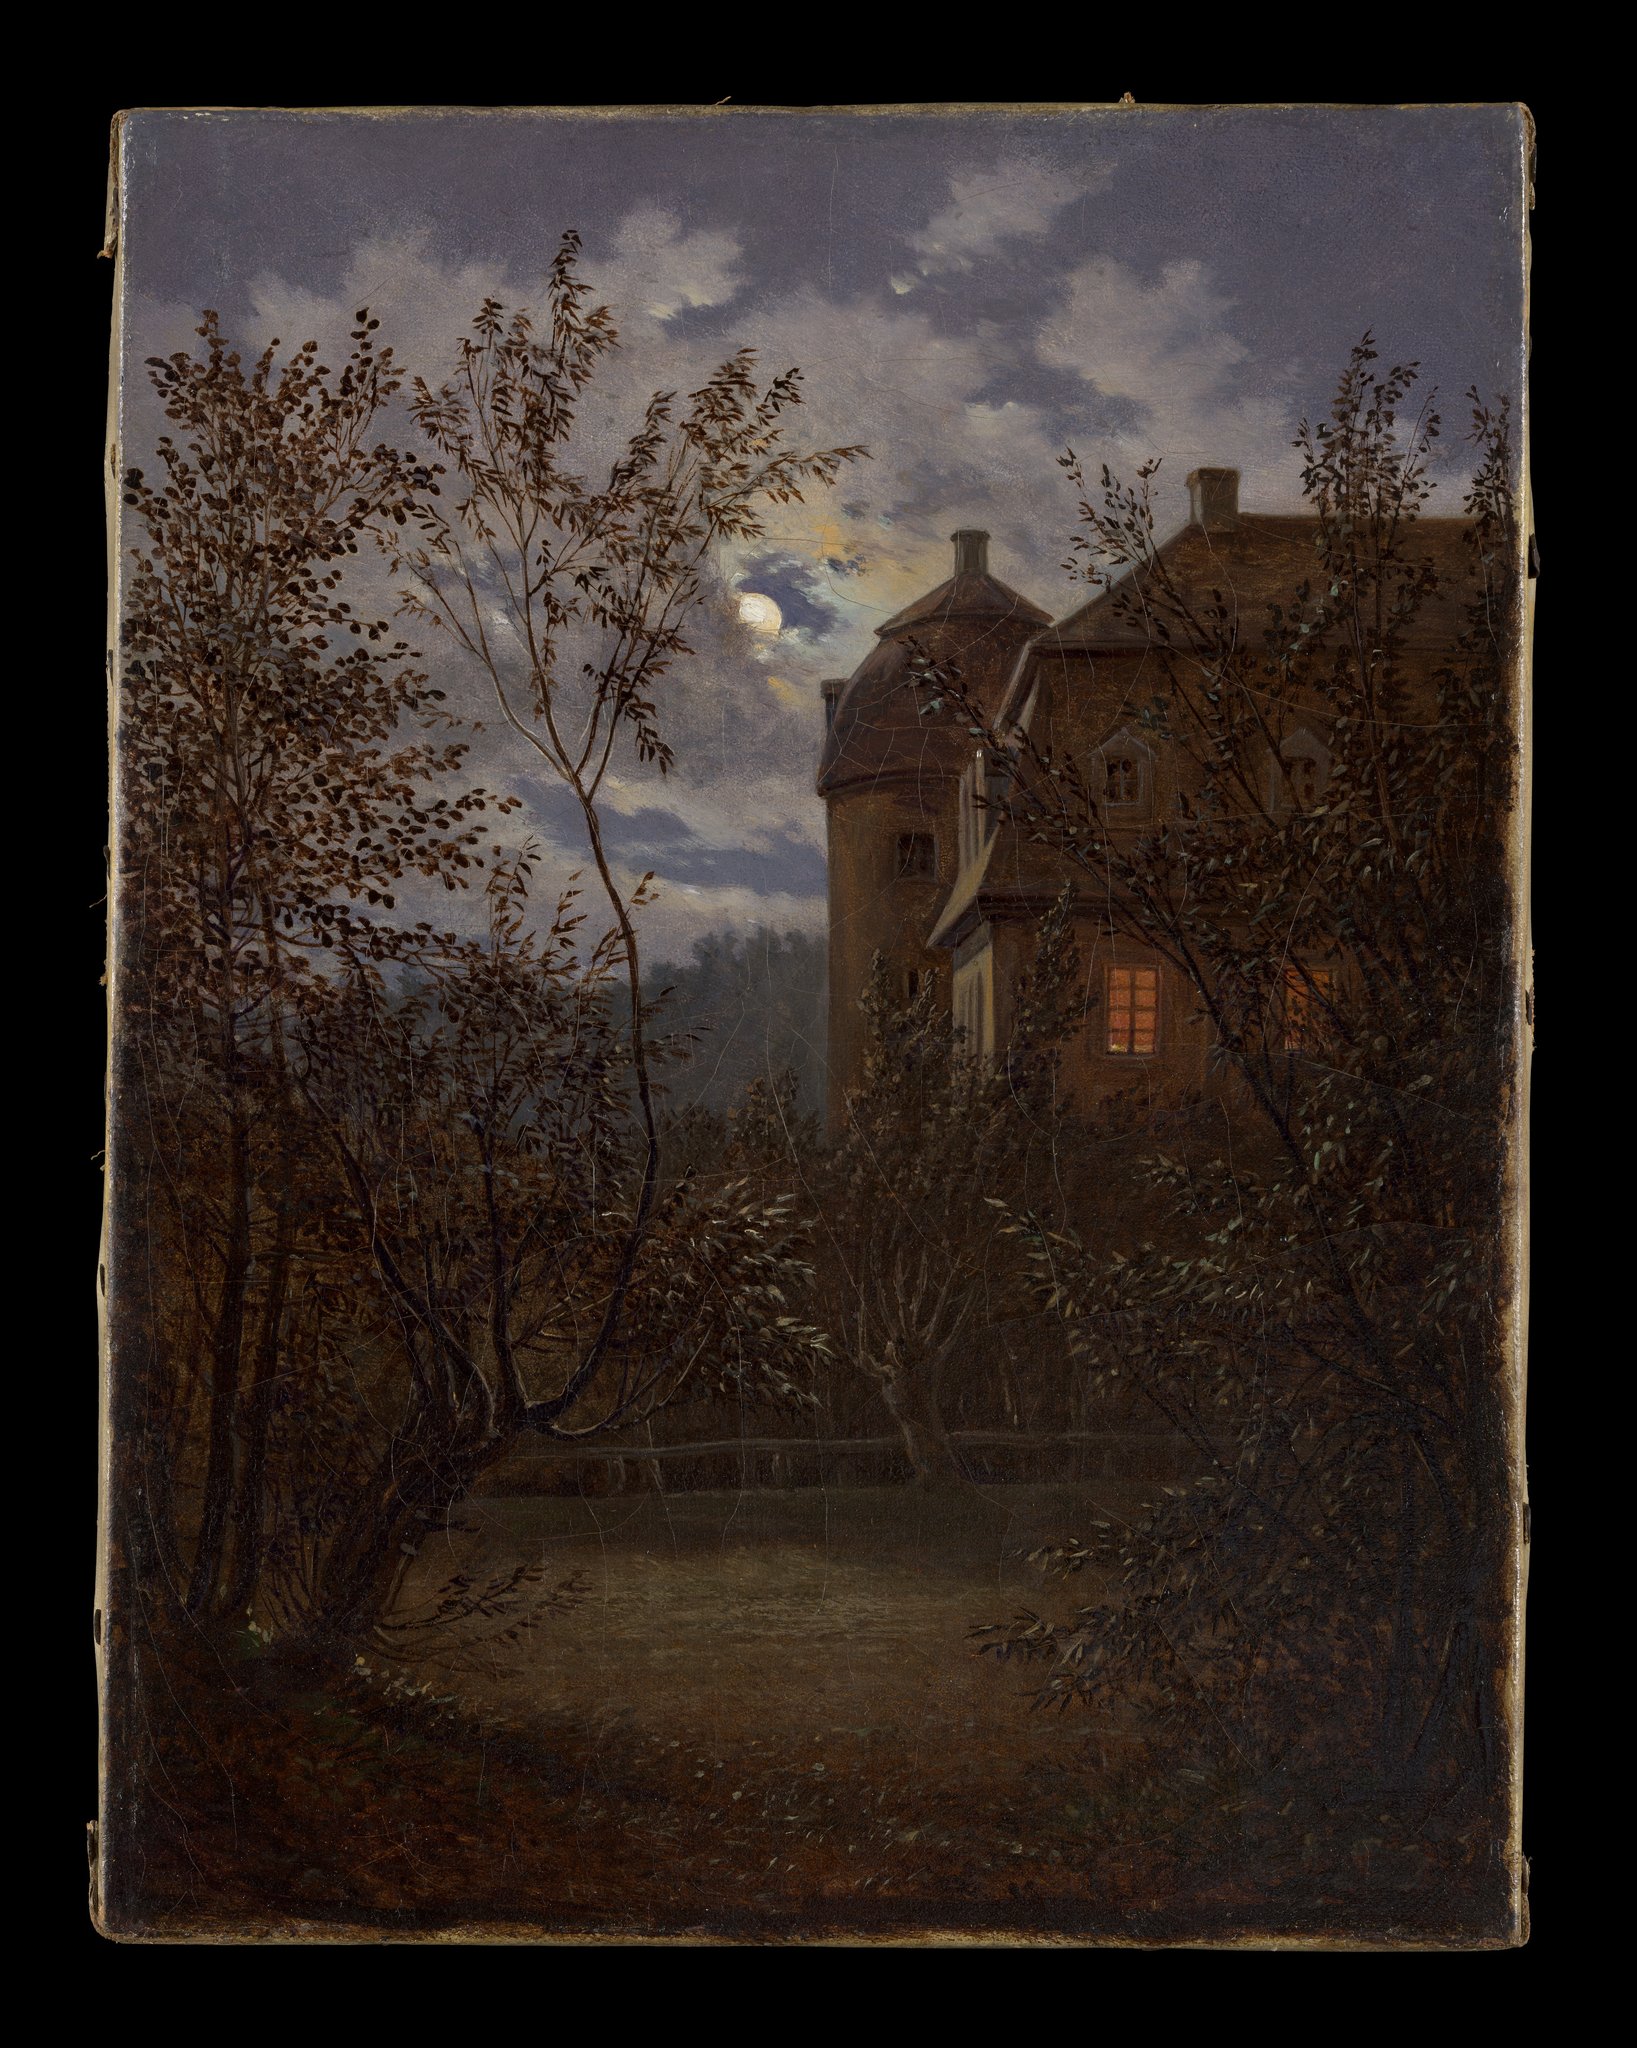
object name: painting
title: Schloss Milkel in Moonlight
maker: carl gustav carus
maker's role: artist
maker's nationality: german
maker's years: 1789-1869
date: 1833-1835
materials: canvas, oil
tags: houses,gardens,night